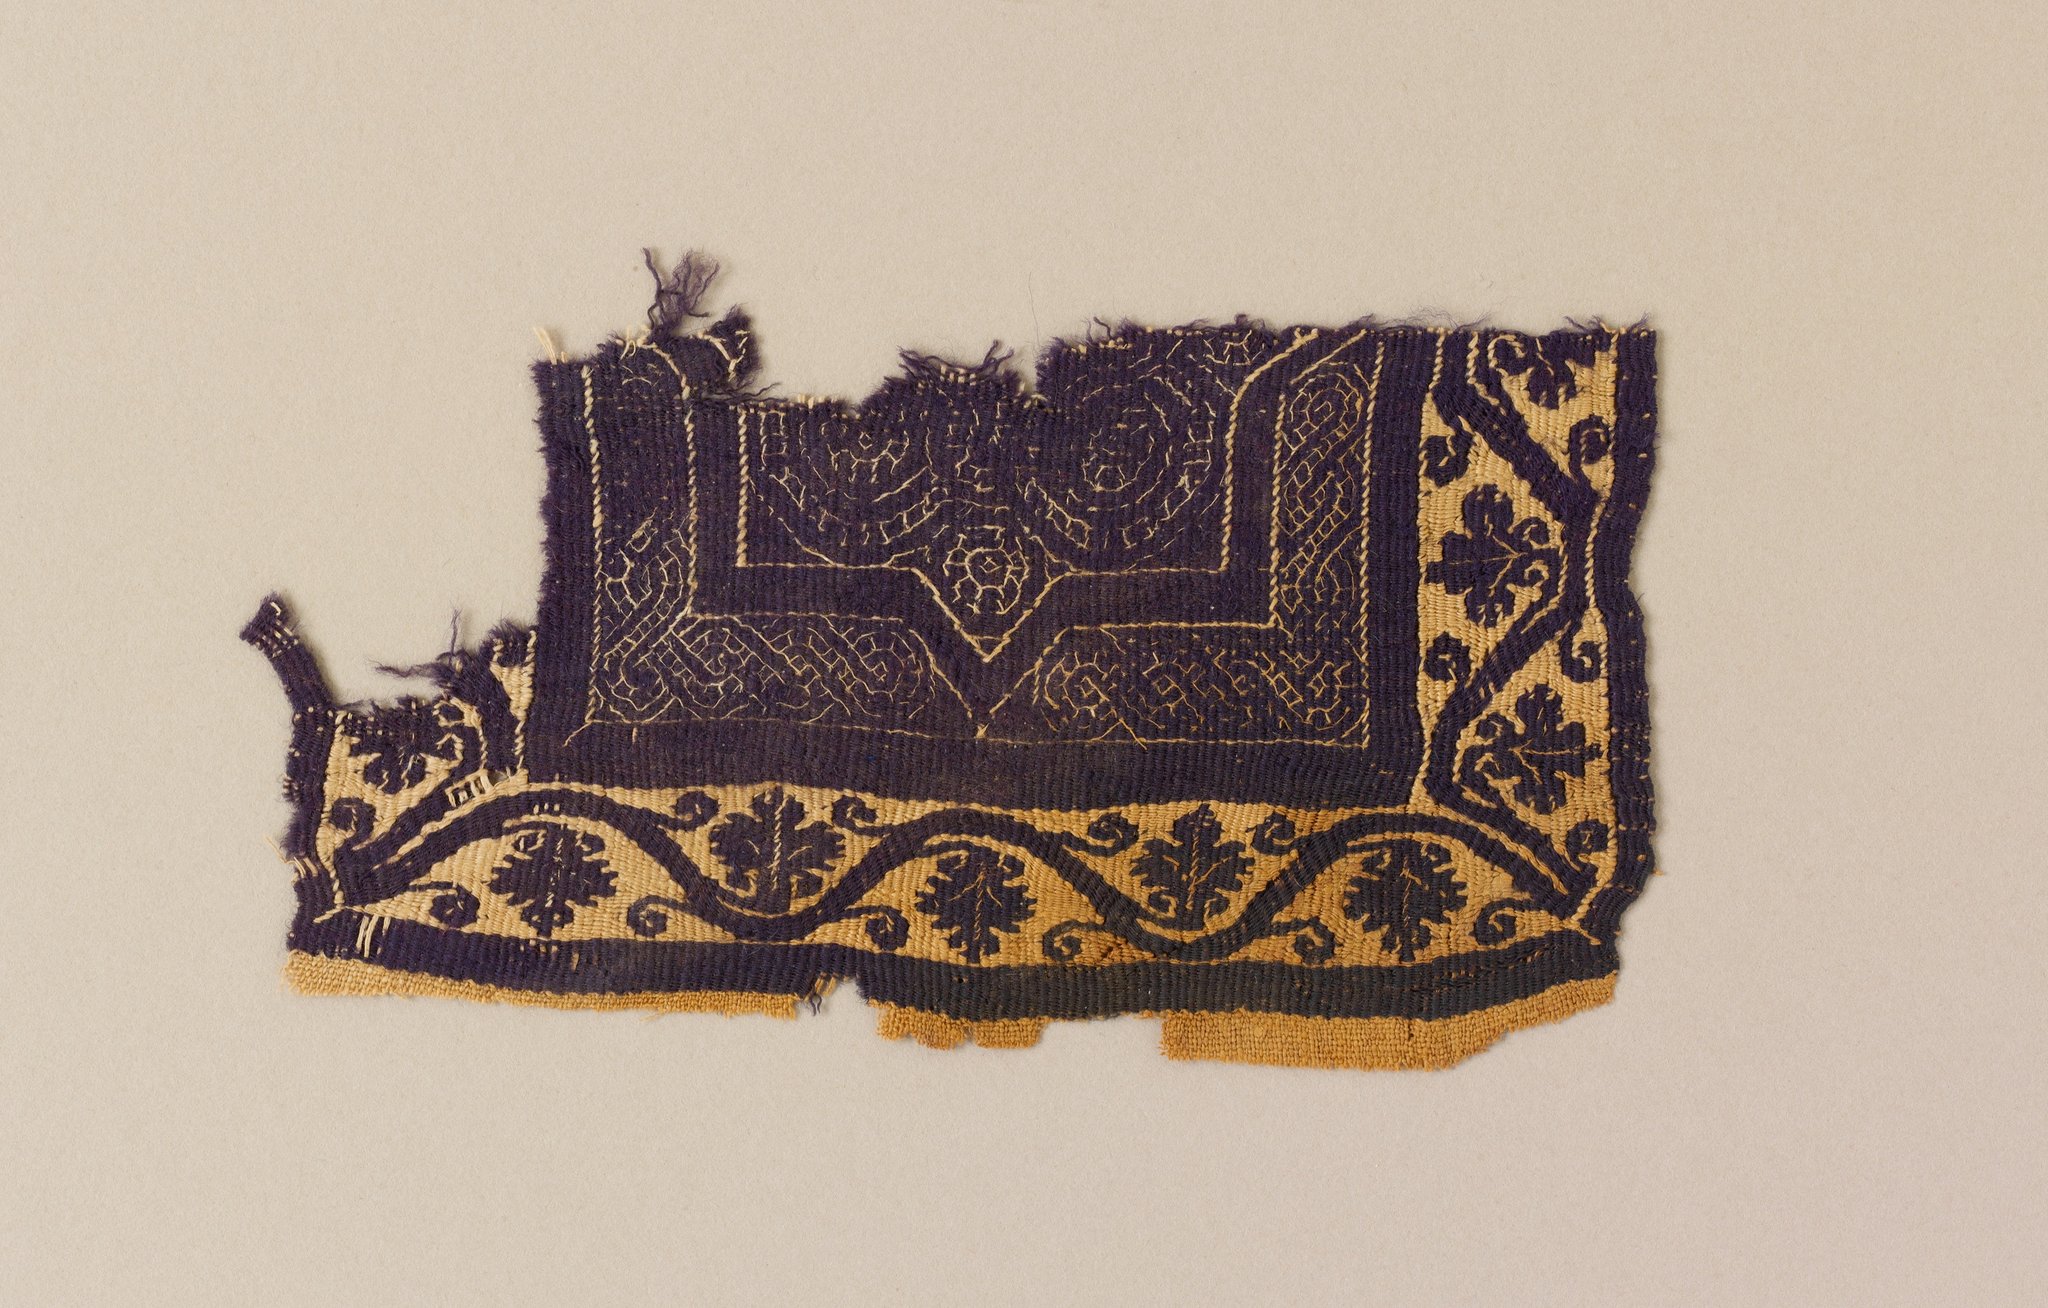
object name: textile fragment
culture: coptic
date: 300-600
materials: linen, wool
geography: egypt